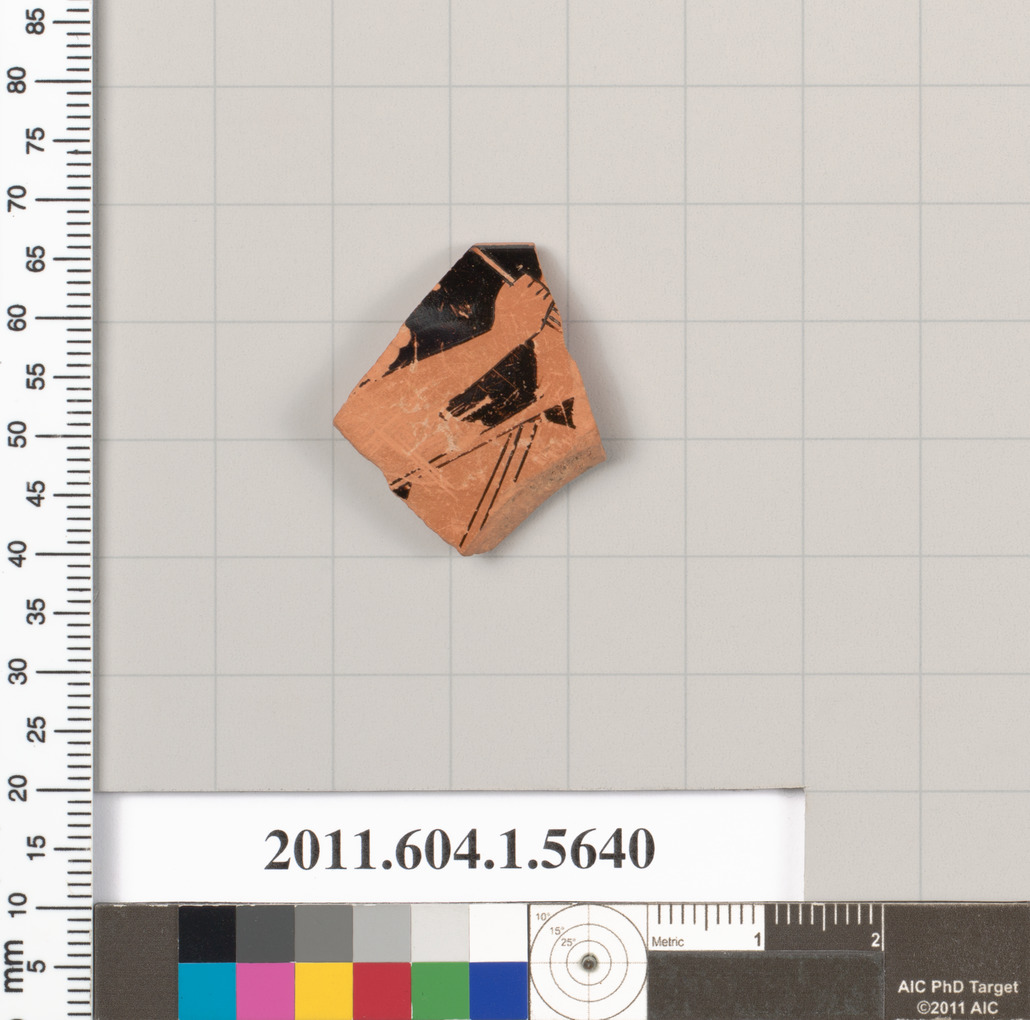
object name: kylix fragment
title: Terracotta rim fragment of a kylix (drinking cup)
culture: greek, attic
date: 500-480 BCE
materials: terracotta